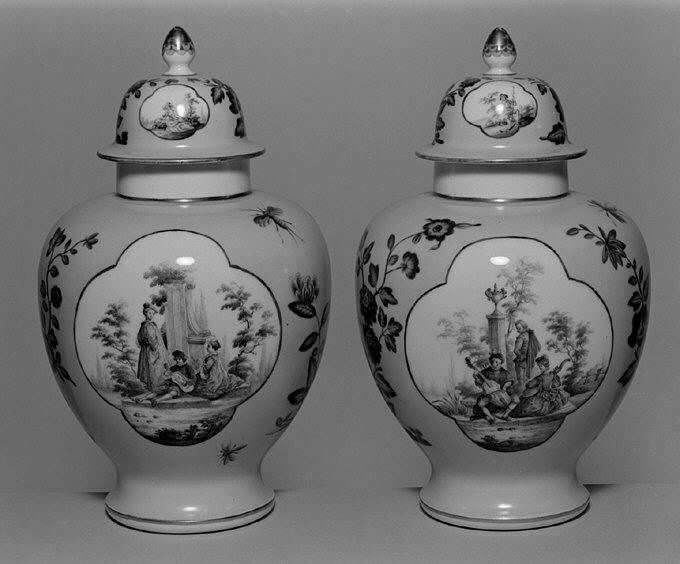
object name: vase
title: Vase (one of a pair)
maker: meissen manufactory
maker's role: manufactory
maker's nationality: german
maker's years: 1710-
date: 1740-1745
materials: hard paste porcelain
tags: men,women,music,trees